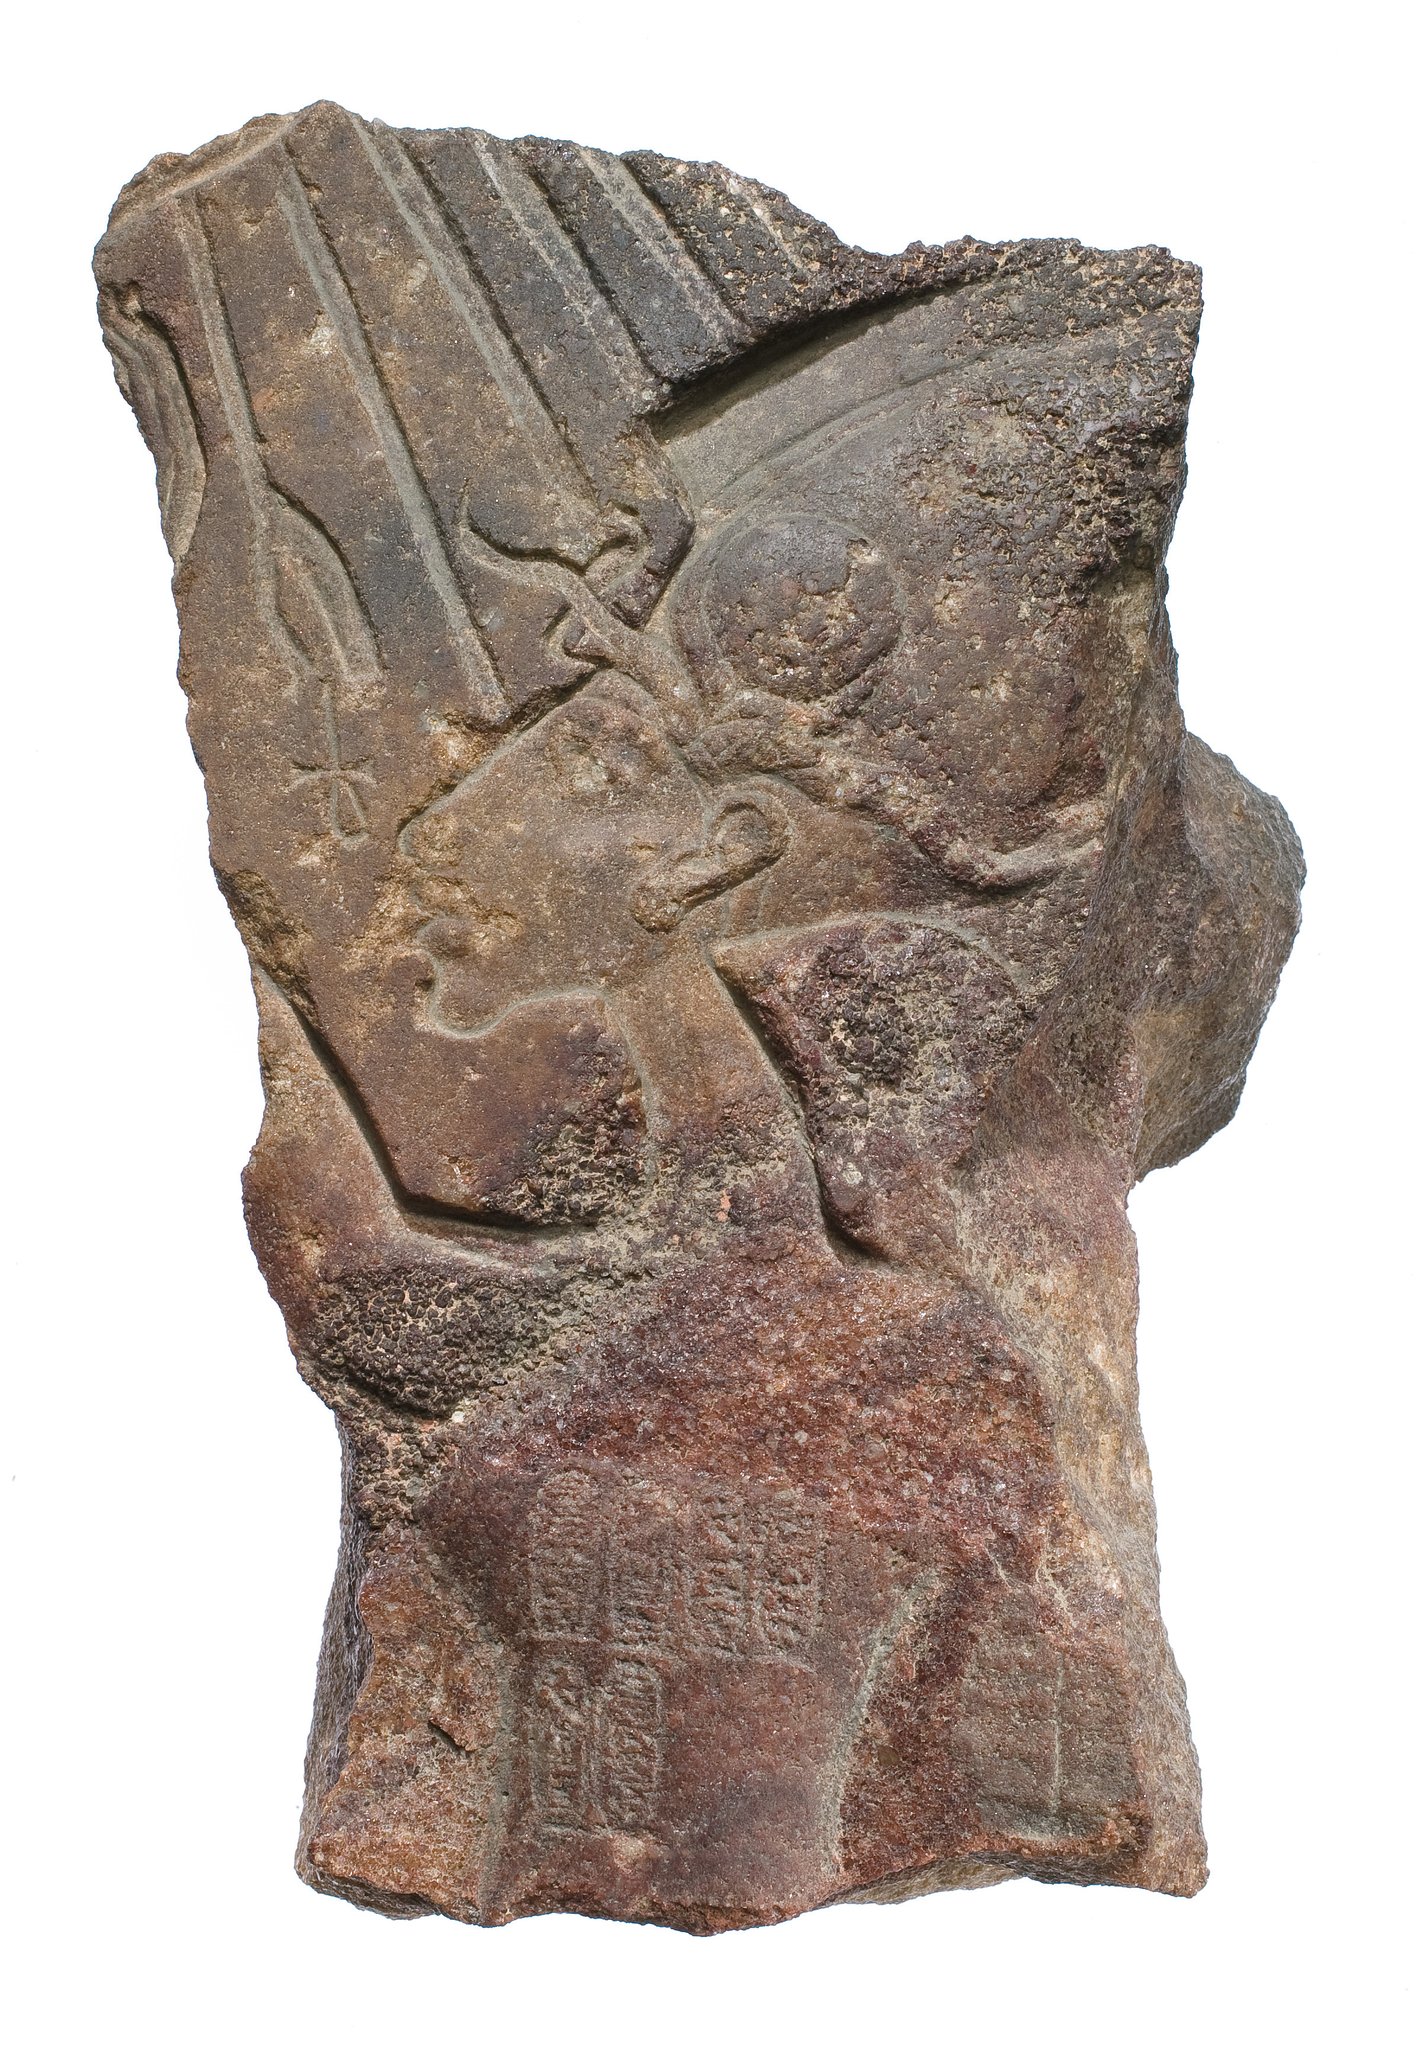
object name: relief, akhenaten, parapet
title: Relief of Akhenaten, probably from a parapet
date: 1353-1336 BCE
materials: quartzite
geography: egypt